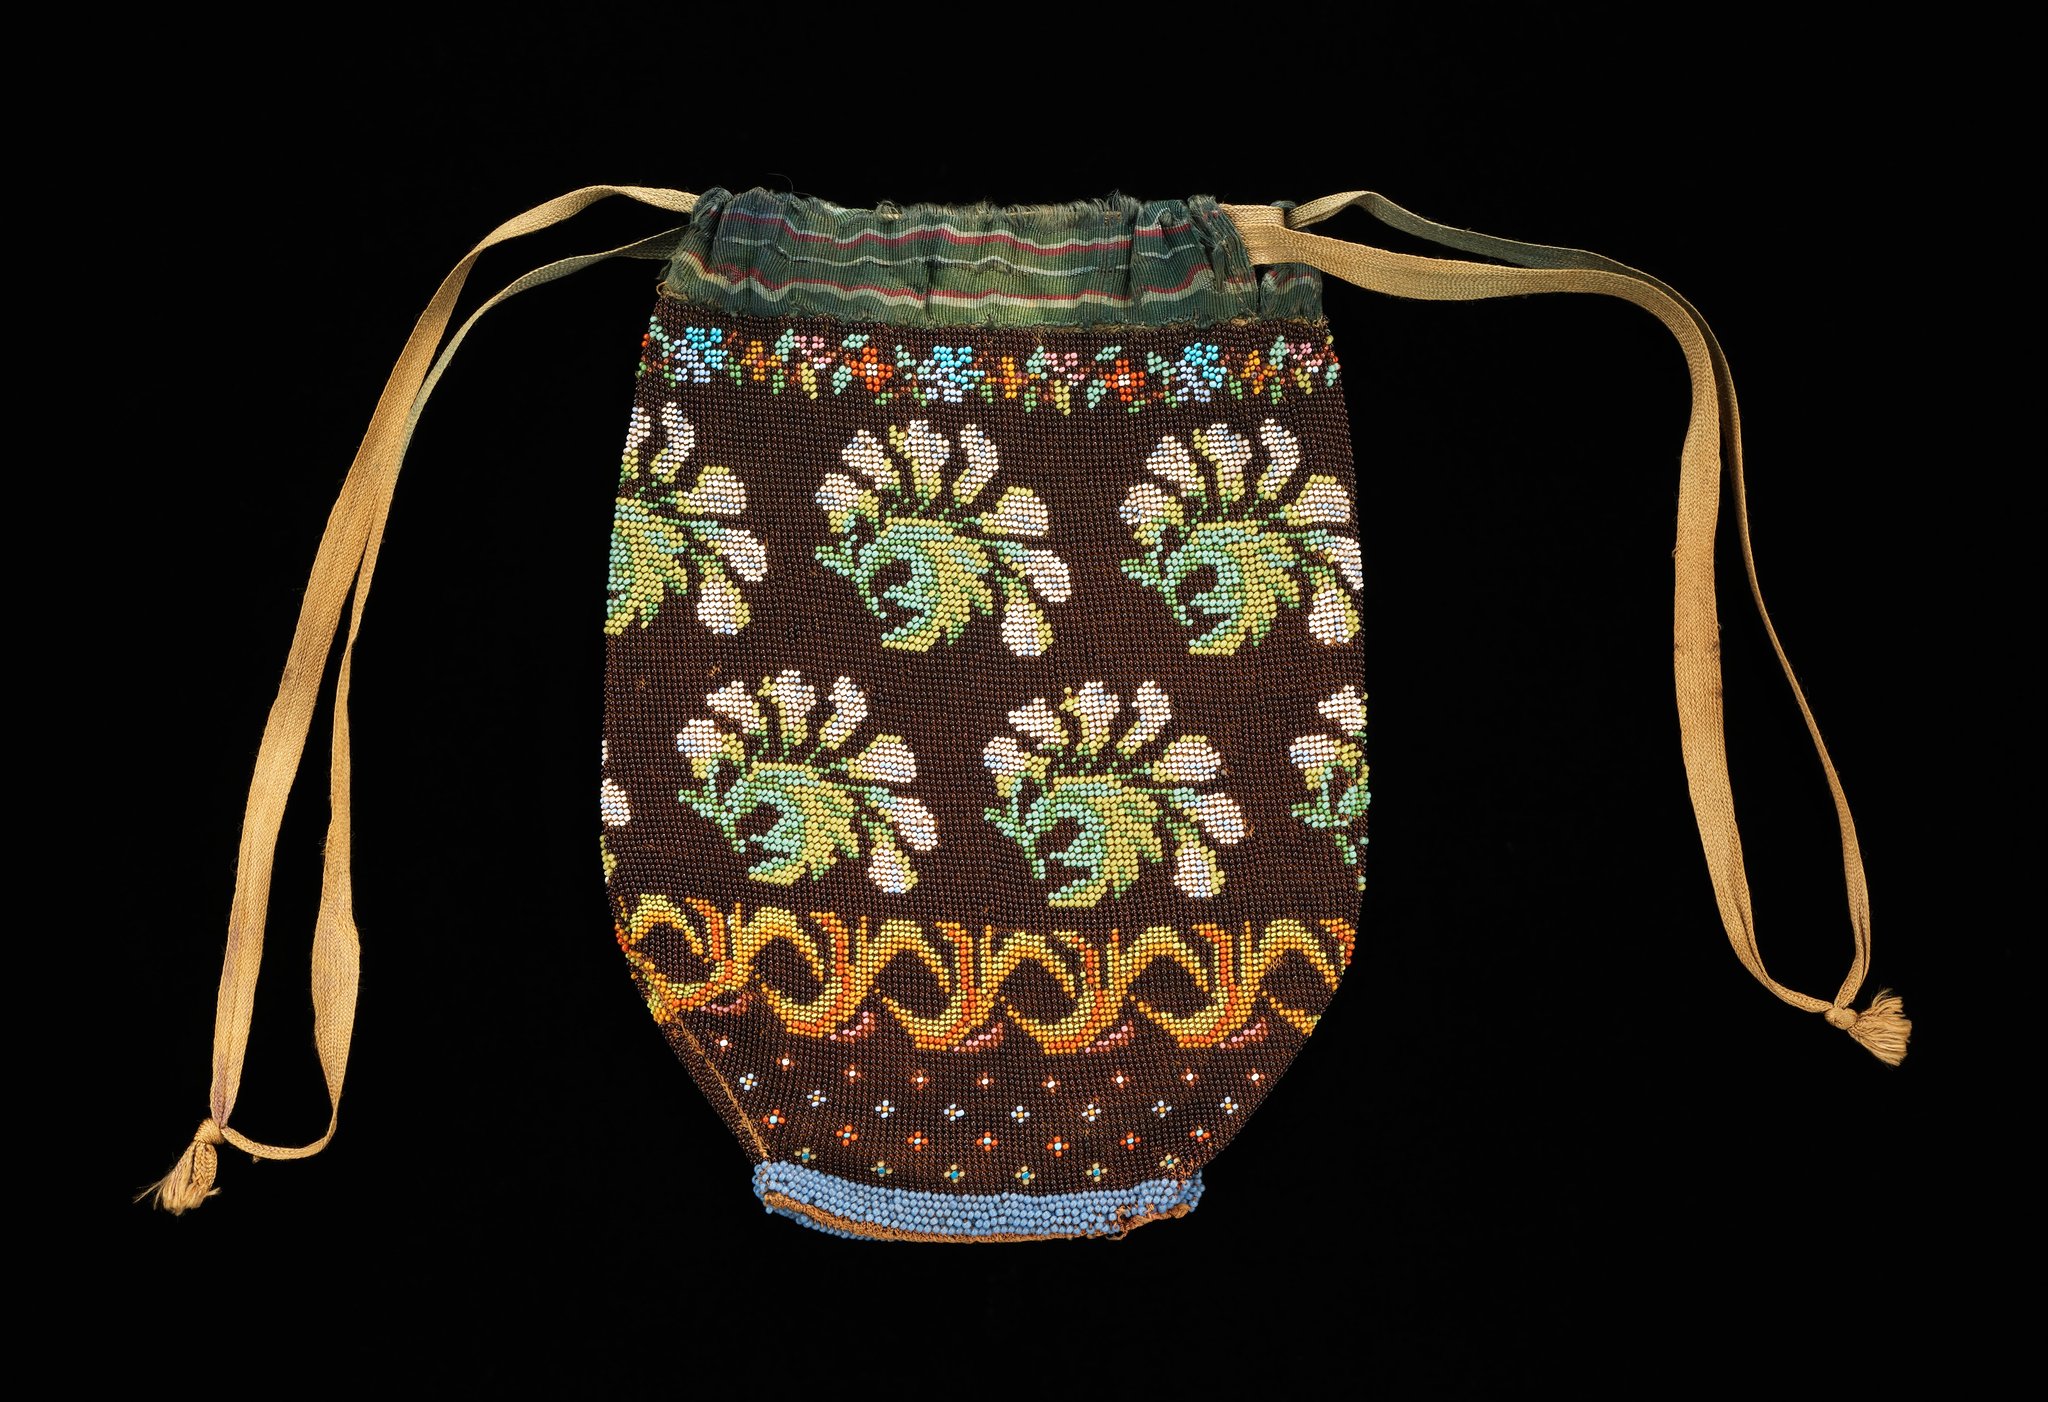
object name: pouch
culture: american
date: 1830-1860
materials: cotton, glass, linen, silk